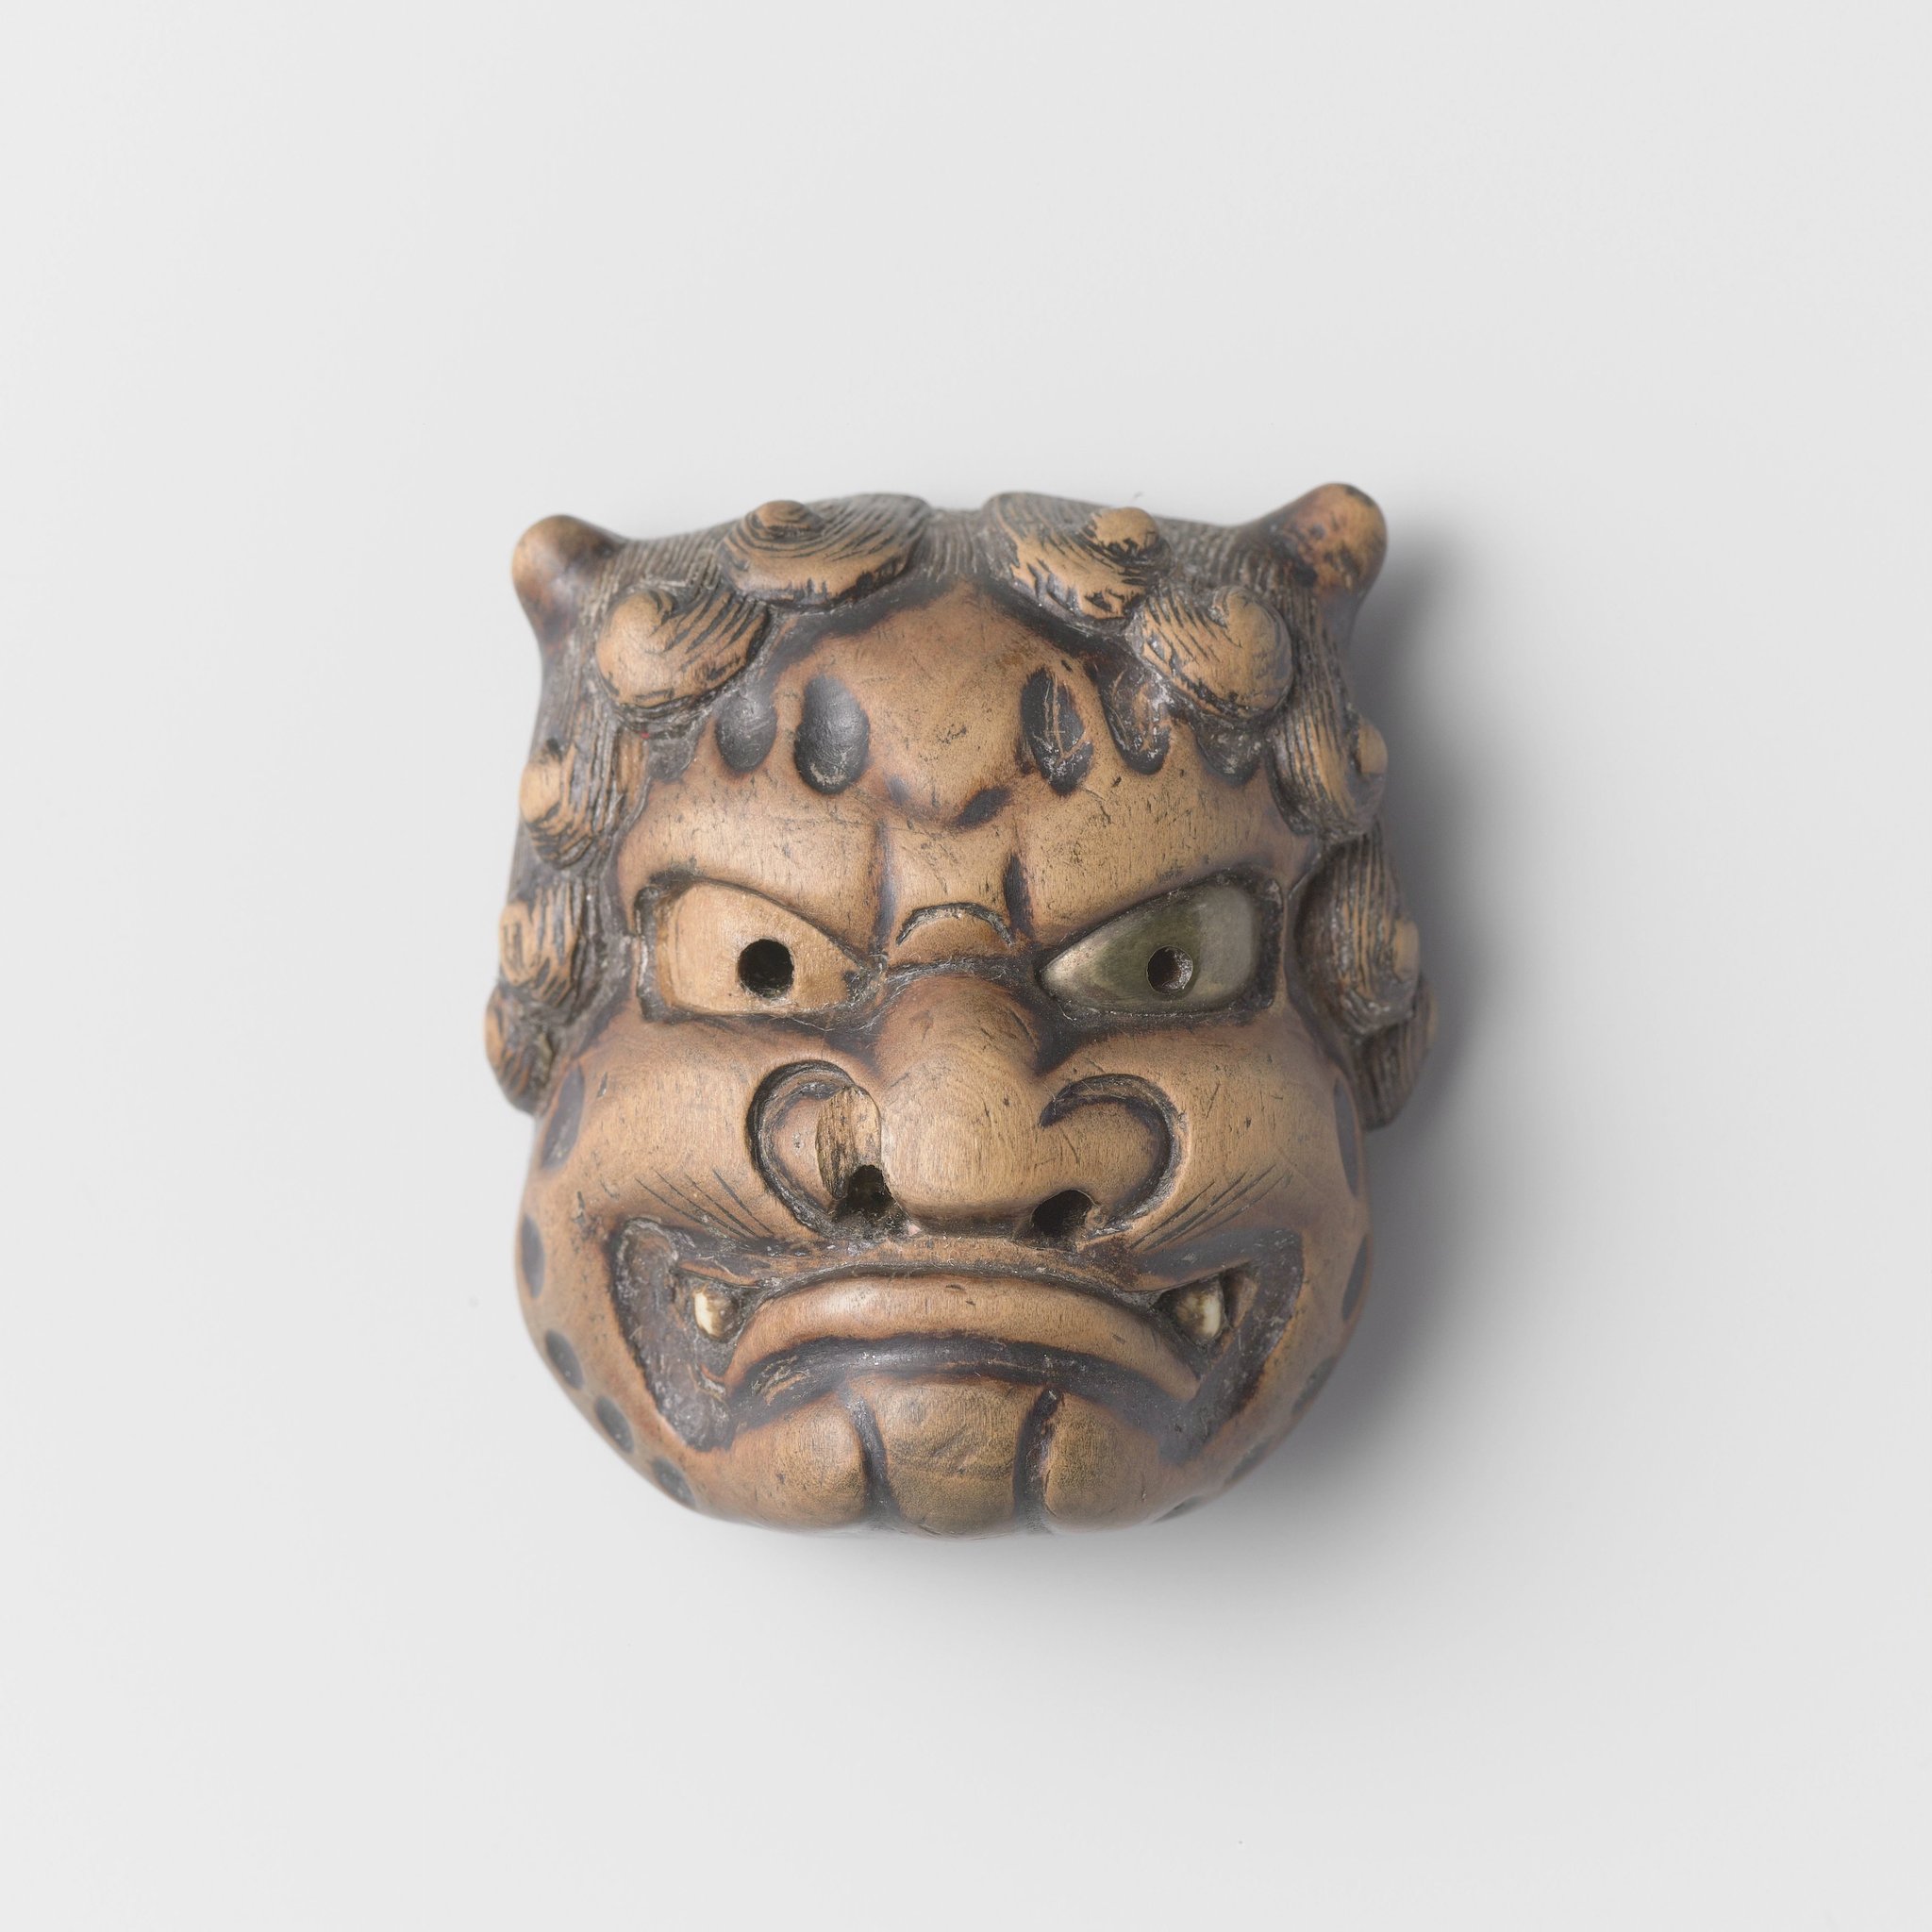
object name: netsuke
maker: nagasada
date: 1850-1900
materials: wood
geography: japan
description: Masker van een oni. Gesigneerd "nagasada".